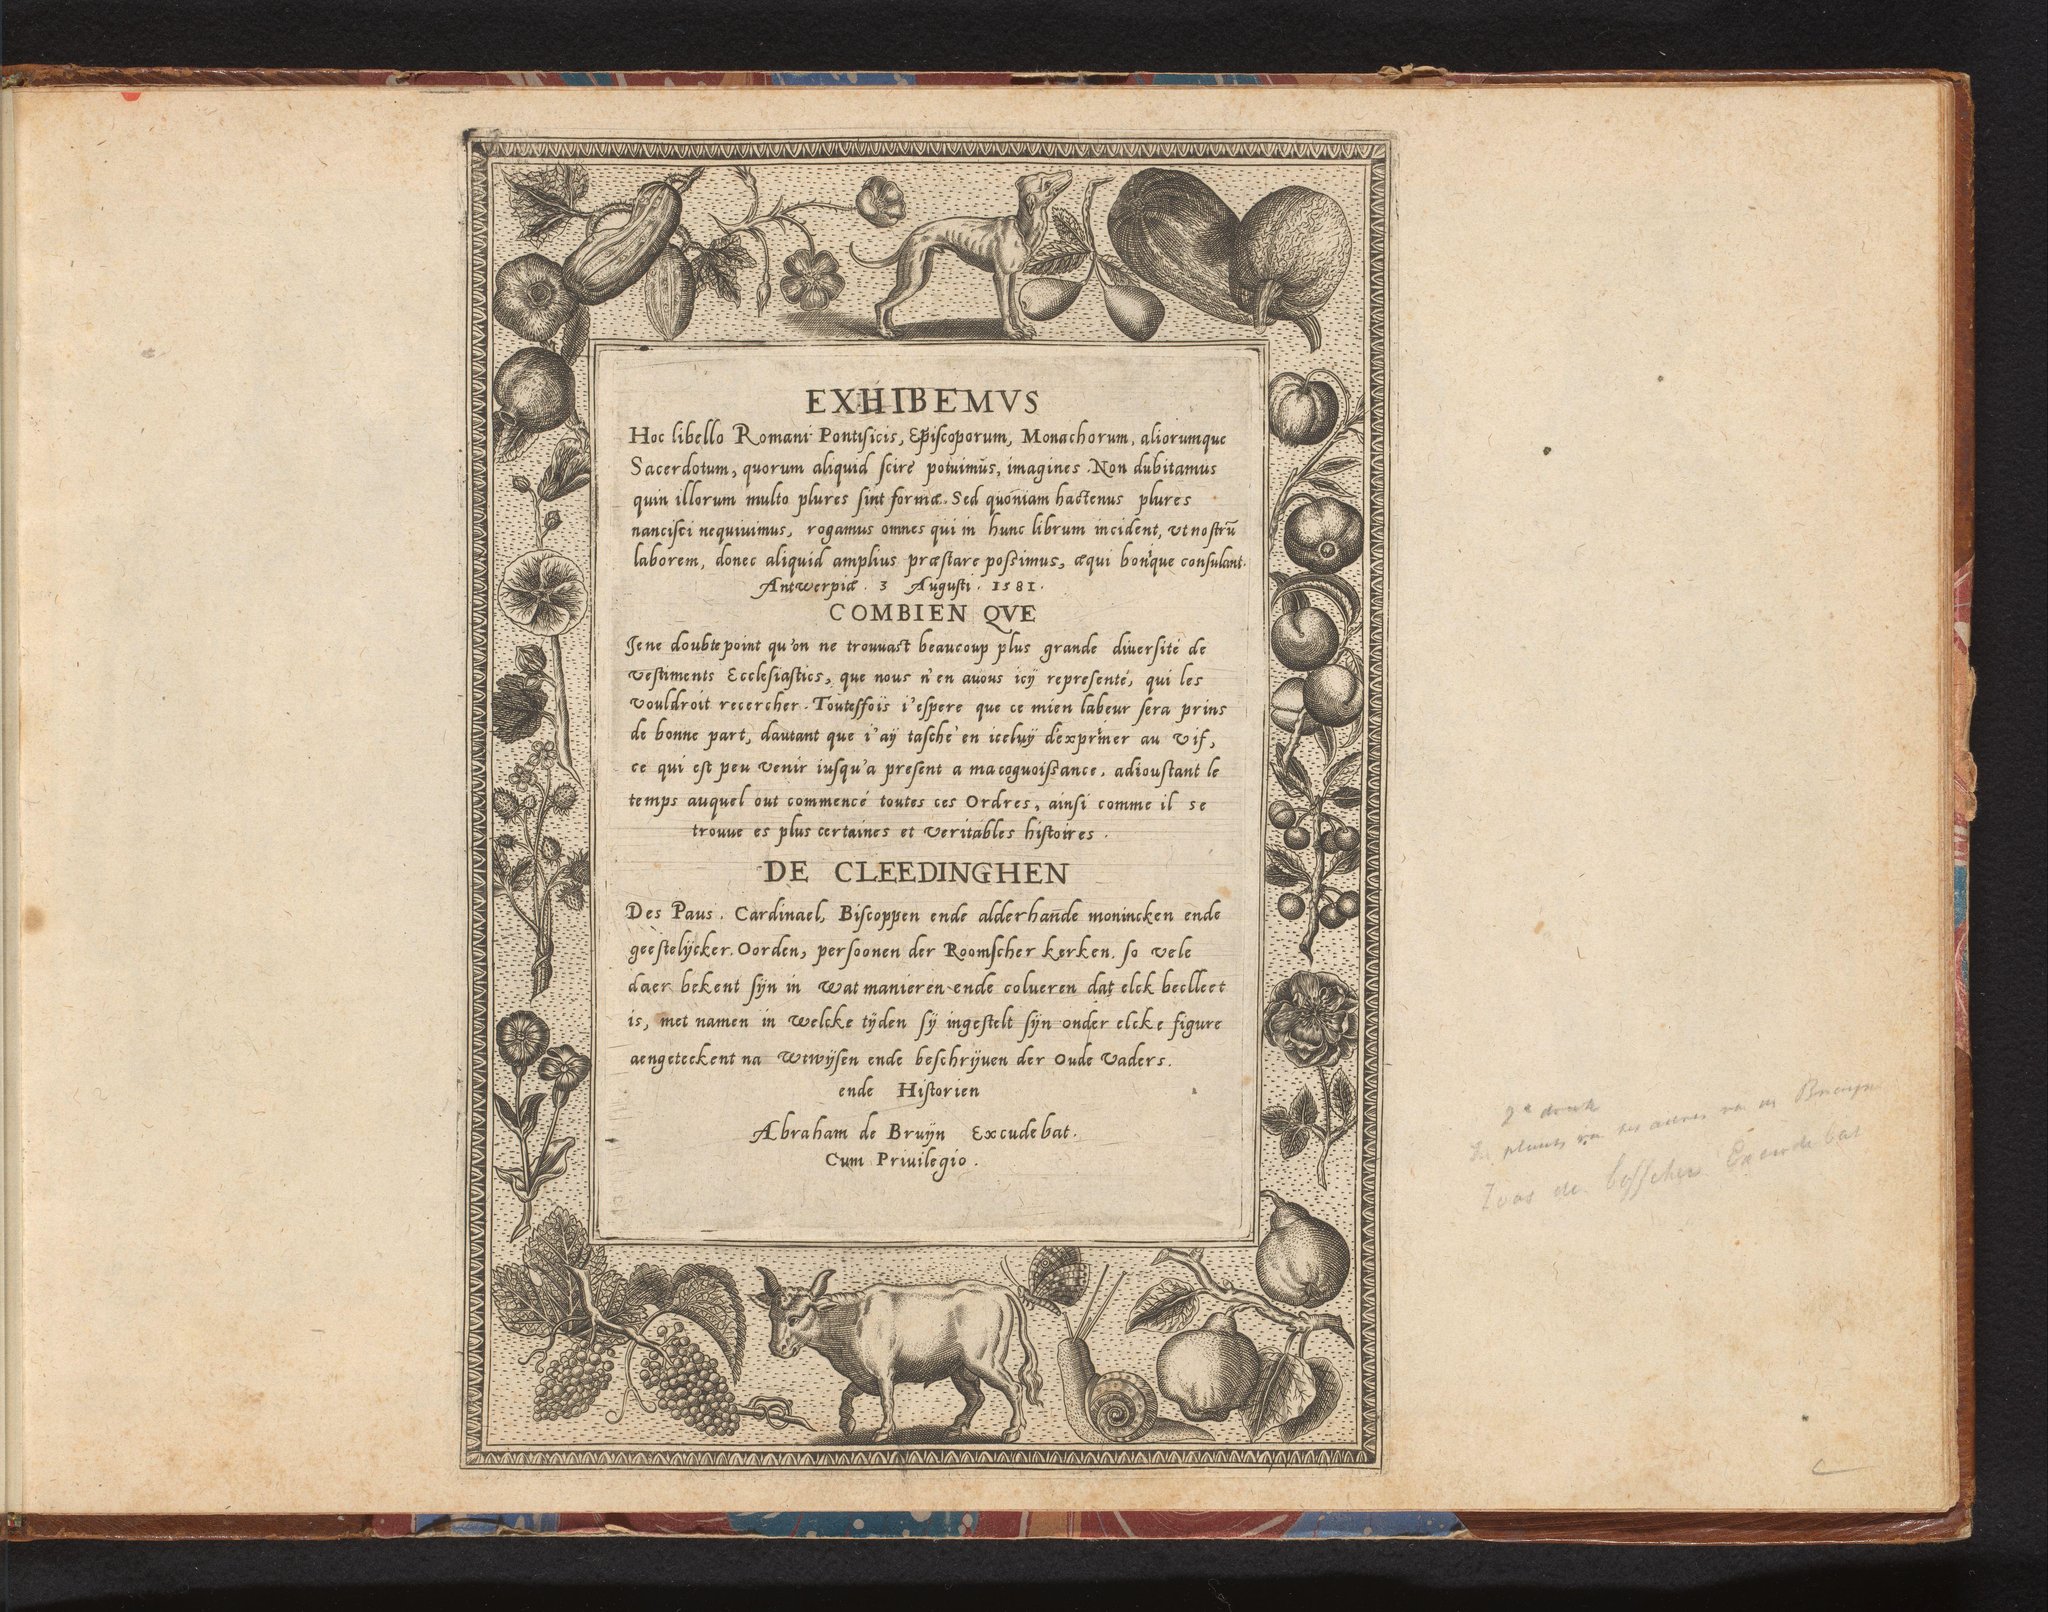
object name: costume print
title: Ornamentrand met vruchten en dieren, waarbinnen tekst over kleding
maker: abraham de bruyn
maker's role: print maker, publisher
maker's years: 1540-1587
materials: paper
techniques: engraving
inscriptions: title: ‘EXHIBEMUS...’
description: Prent uit het boek 'Omnium pene Europae, Asiae, Aphricae atque Americae gentium habitus...', 1581. De prent maakt deel uit van een album.